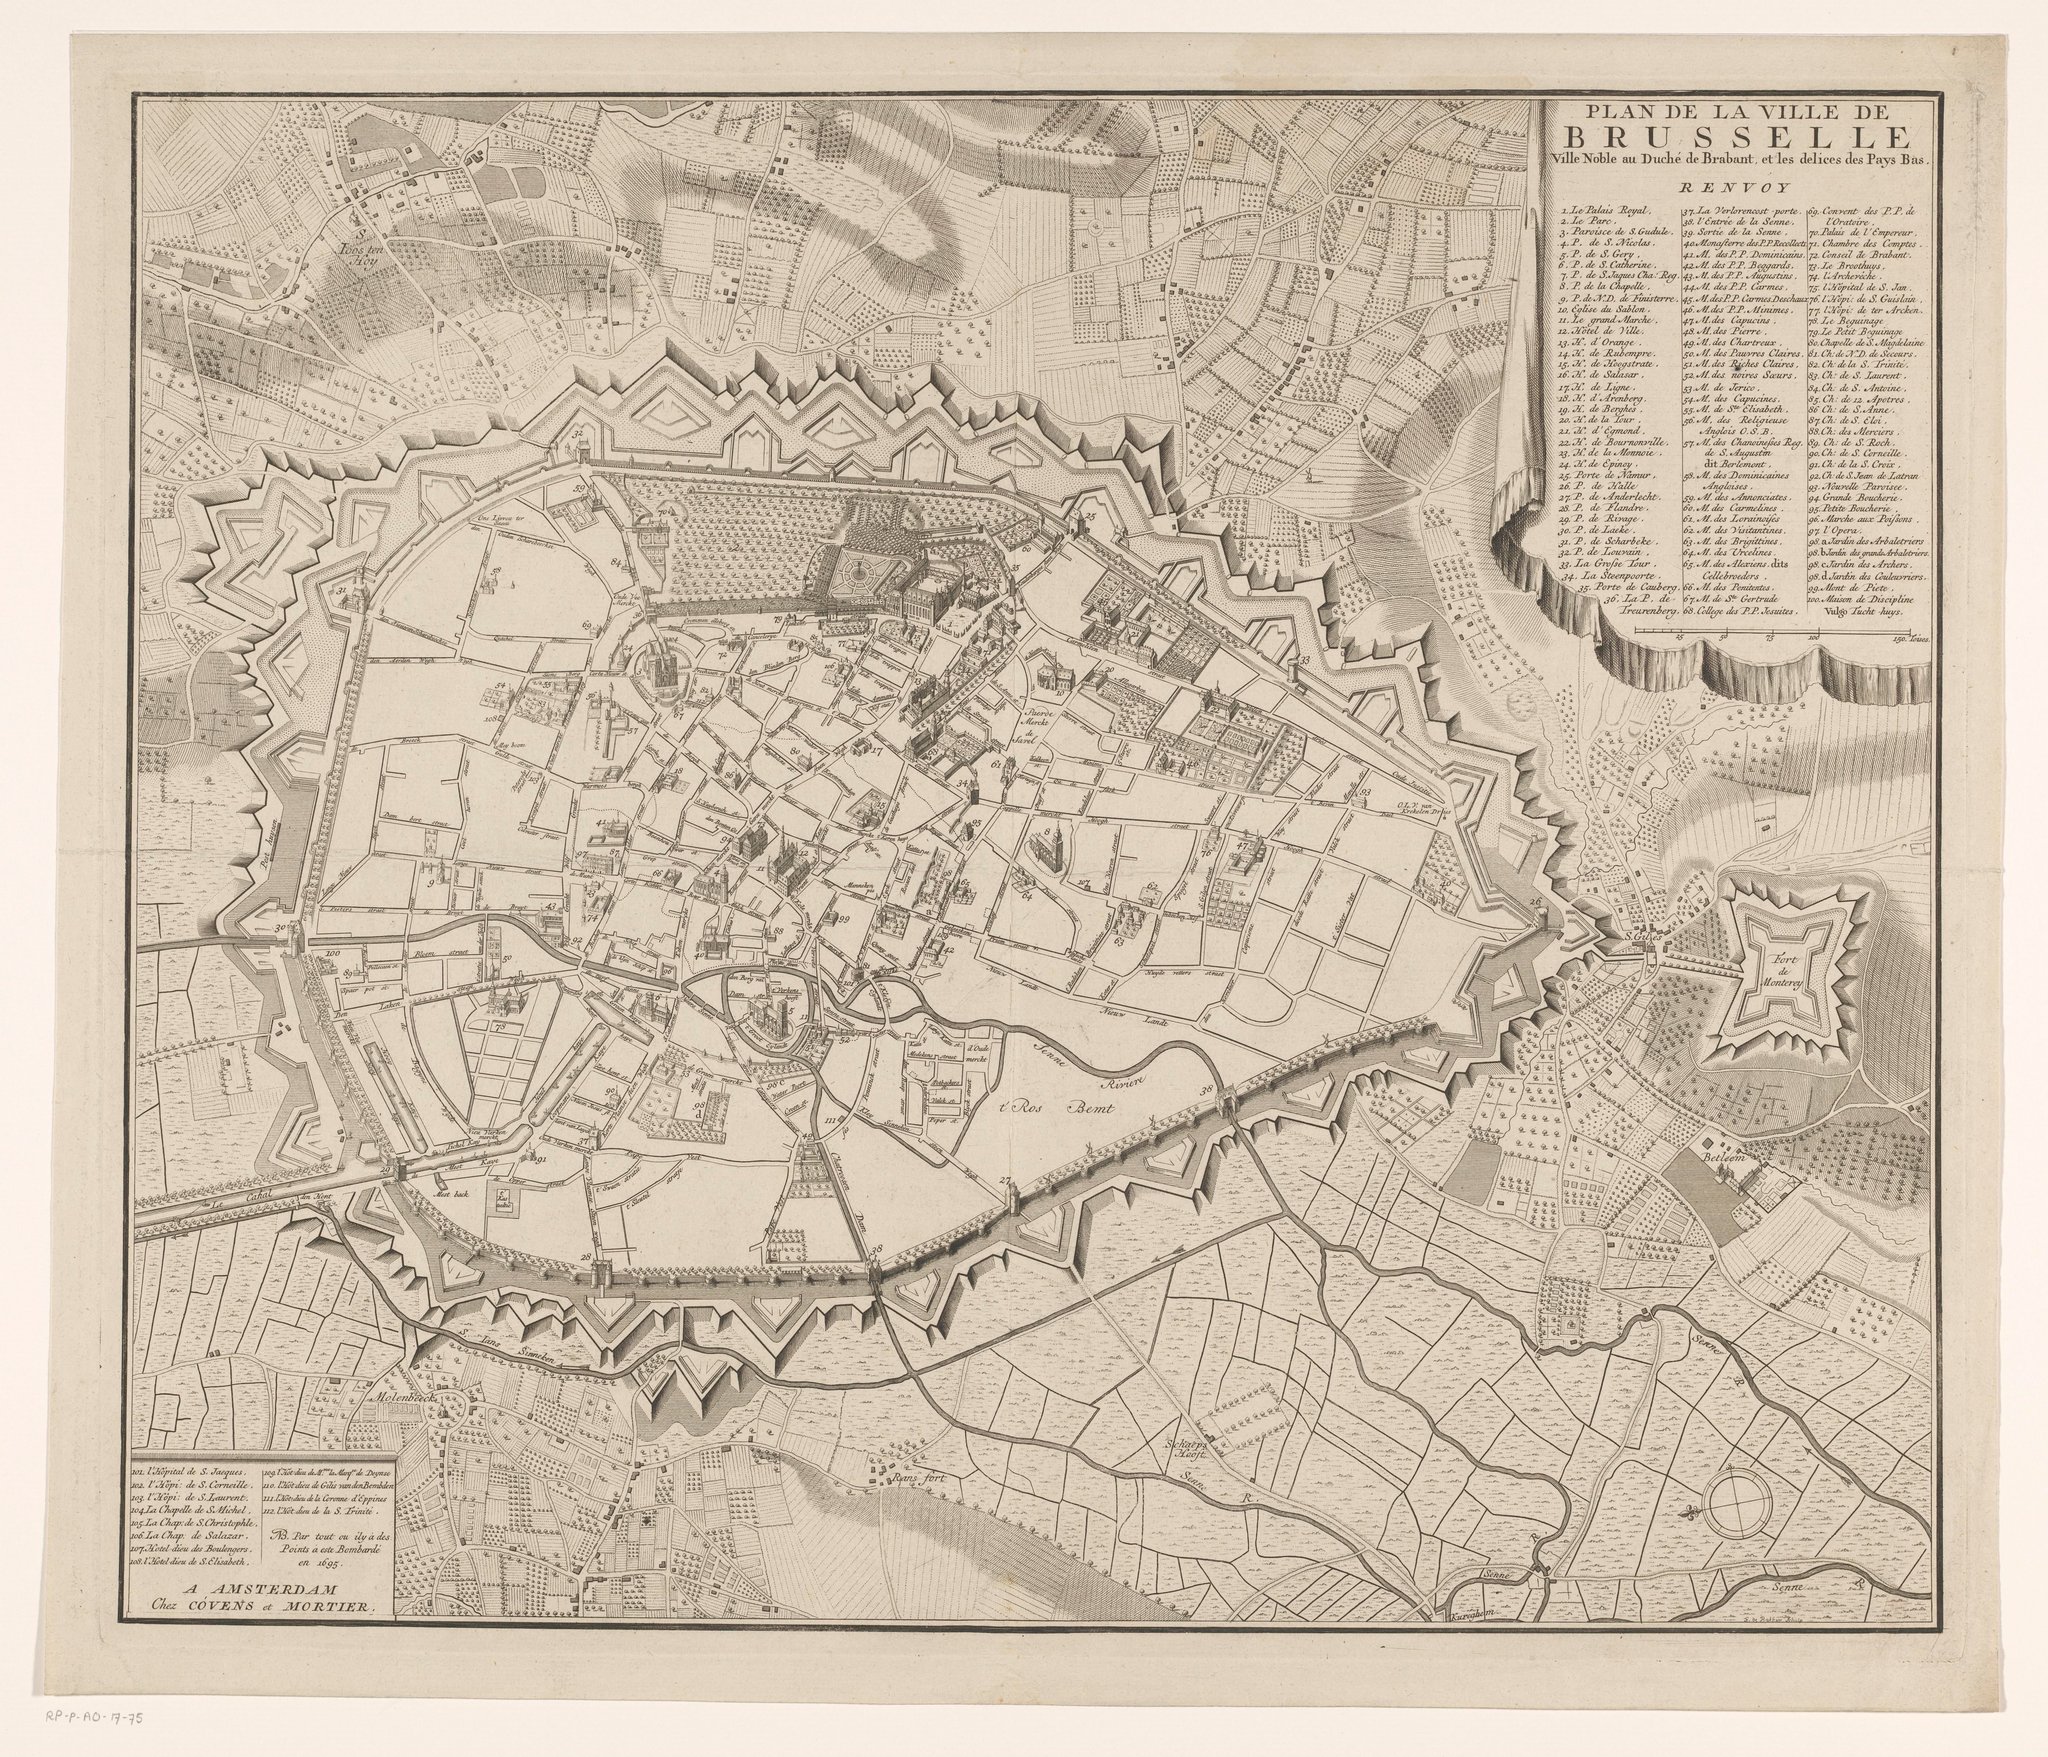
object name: print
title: Plattegrond van Brussel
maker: frans de bakker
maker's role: print maker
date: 1736-1774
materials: paper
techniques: engraving, etching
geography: amsterdam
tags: fortified city, maps of cities, brussels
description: Plattegrond van Brussel met gebouwen in vogelvluchtperspectief. Rechtsboven een cartouche met titel, legenda 1-100 en schaalstok: 150 Toises. Linksonder een kader met het vervolg van de legenda, 101-112.